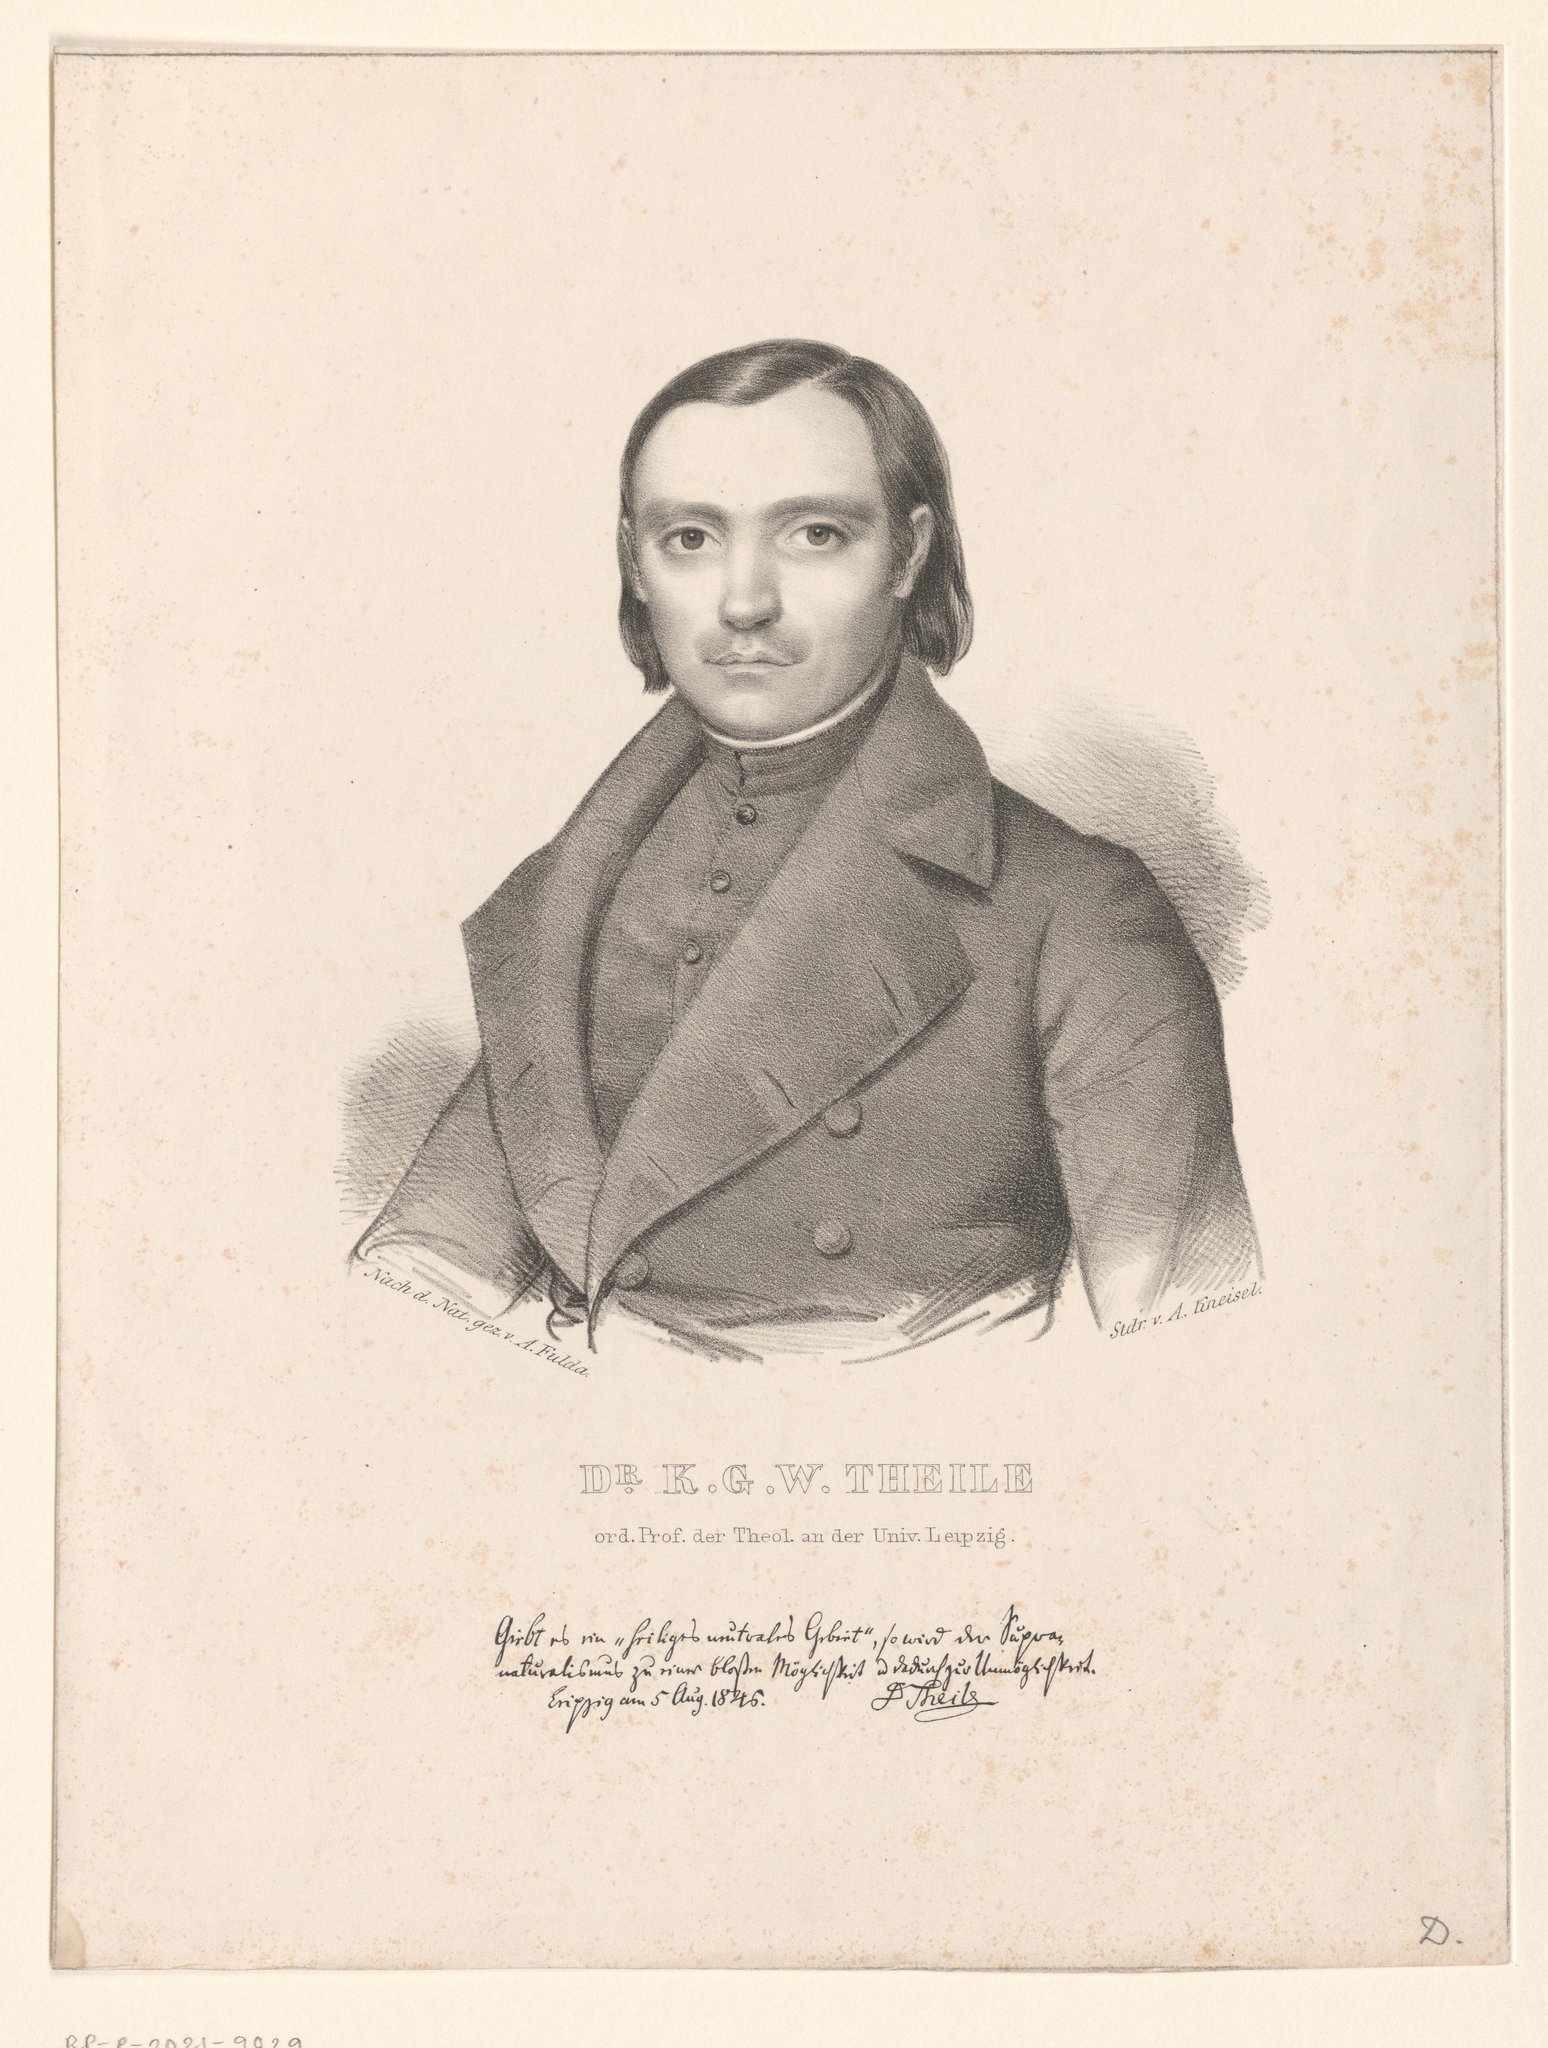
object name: print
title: Portret van Karl Gottfried Wilhelm Theile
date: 1846-1854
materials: paper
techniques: lithograph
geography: leipzig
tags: adult man, historical persons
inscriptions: collector's mark: Lugt 2228